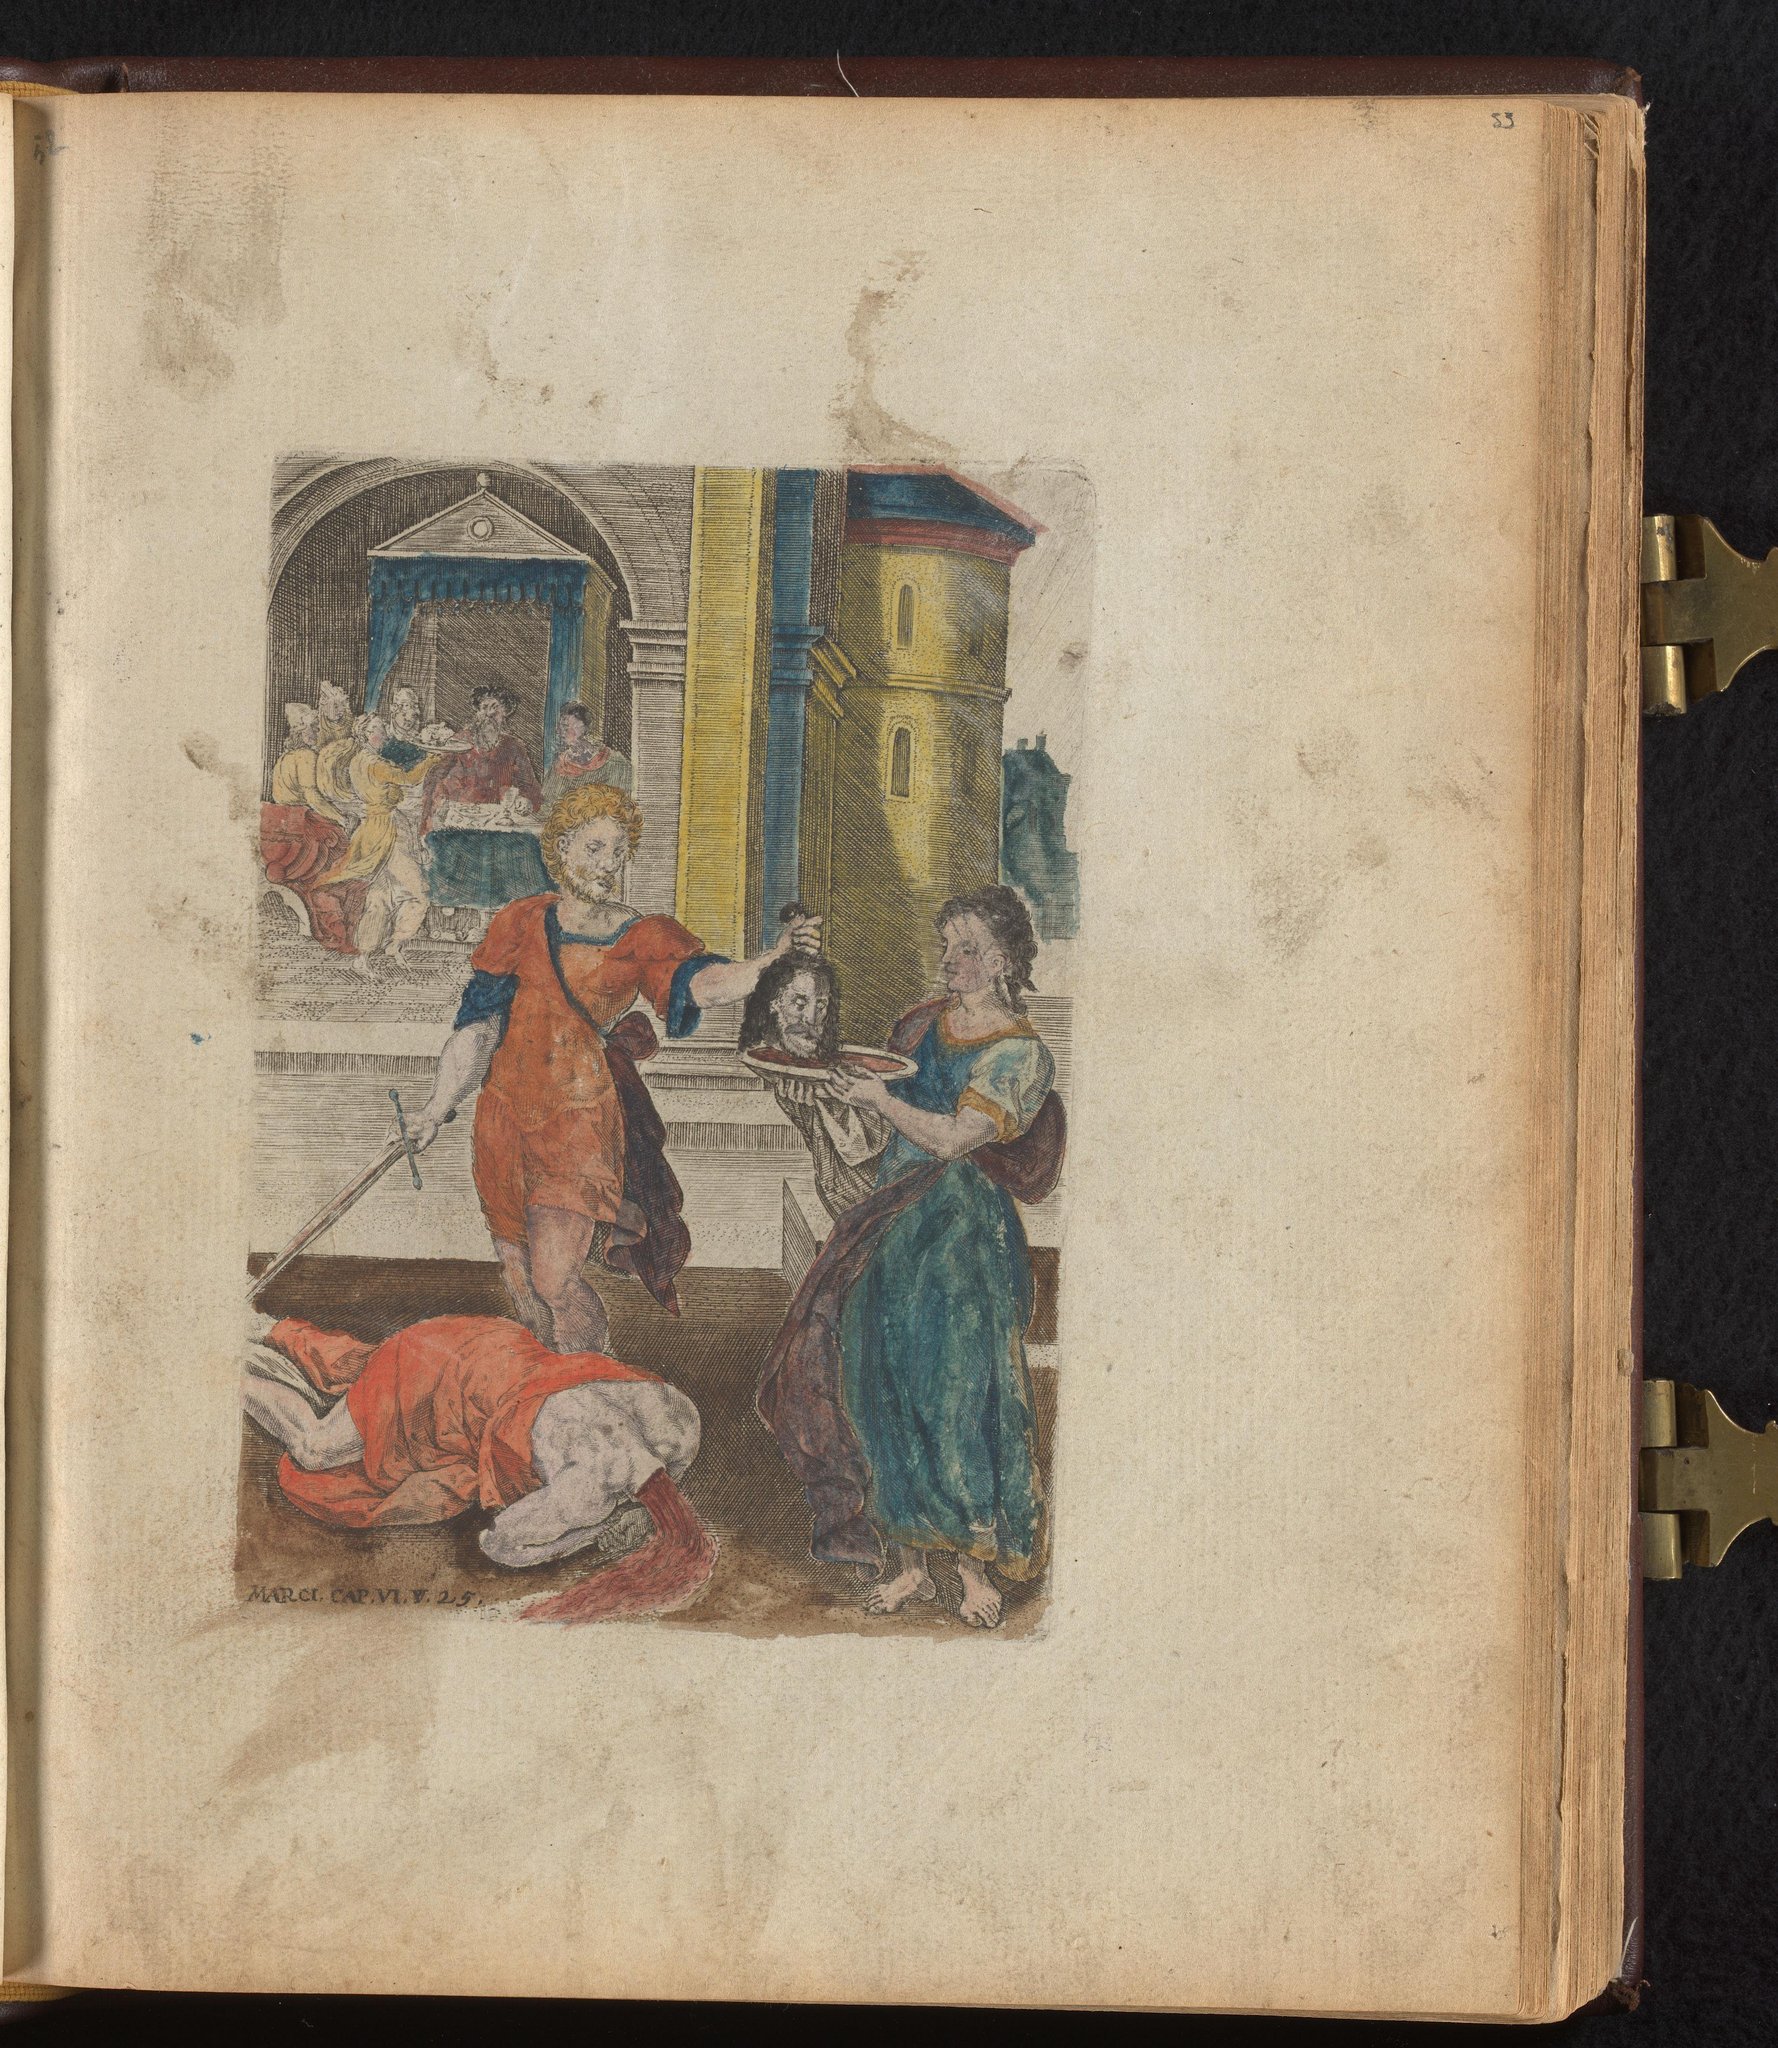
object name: album leaf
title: Onthoofding van Johannes de Doper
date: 1583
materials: paper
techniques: engraving, hand coloring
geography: antwerp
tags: the beheading of john the baptist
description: Eerdere staat van prent gebruikt als boekillustratie in: Biblia Sacra. Antwerpen: Christoffel Plantijn, 1583.